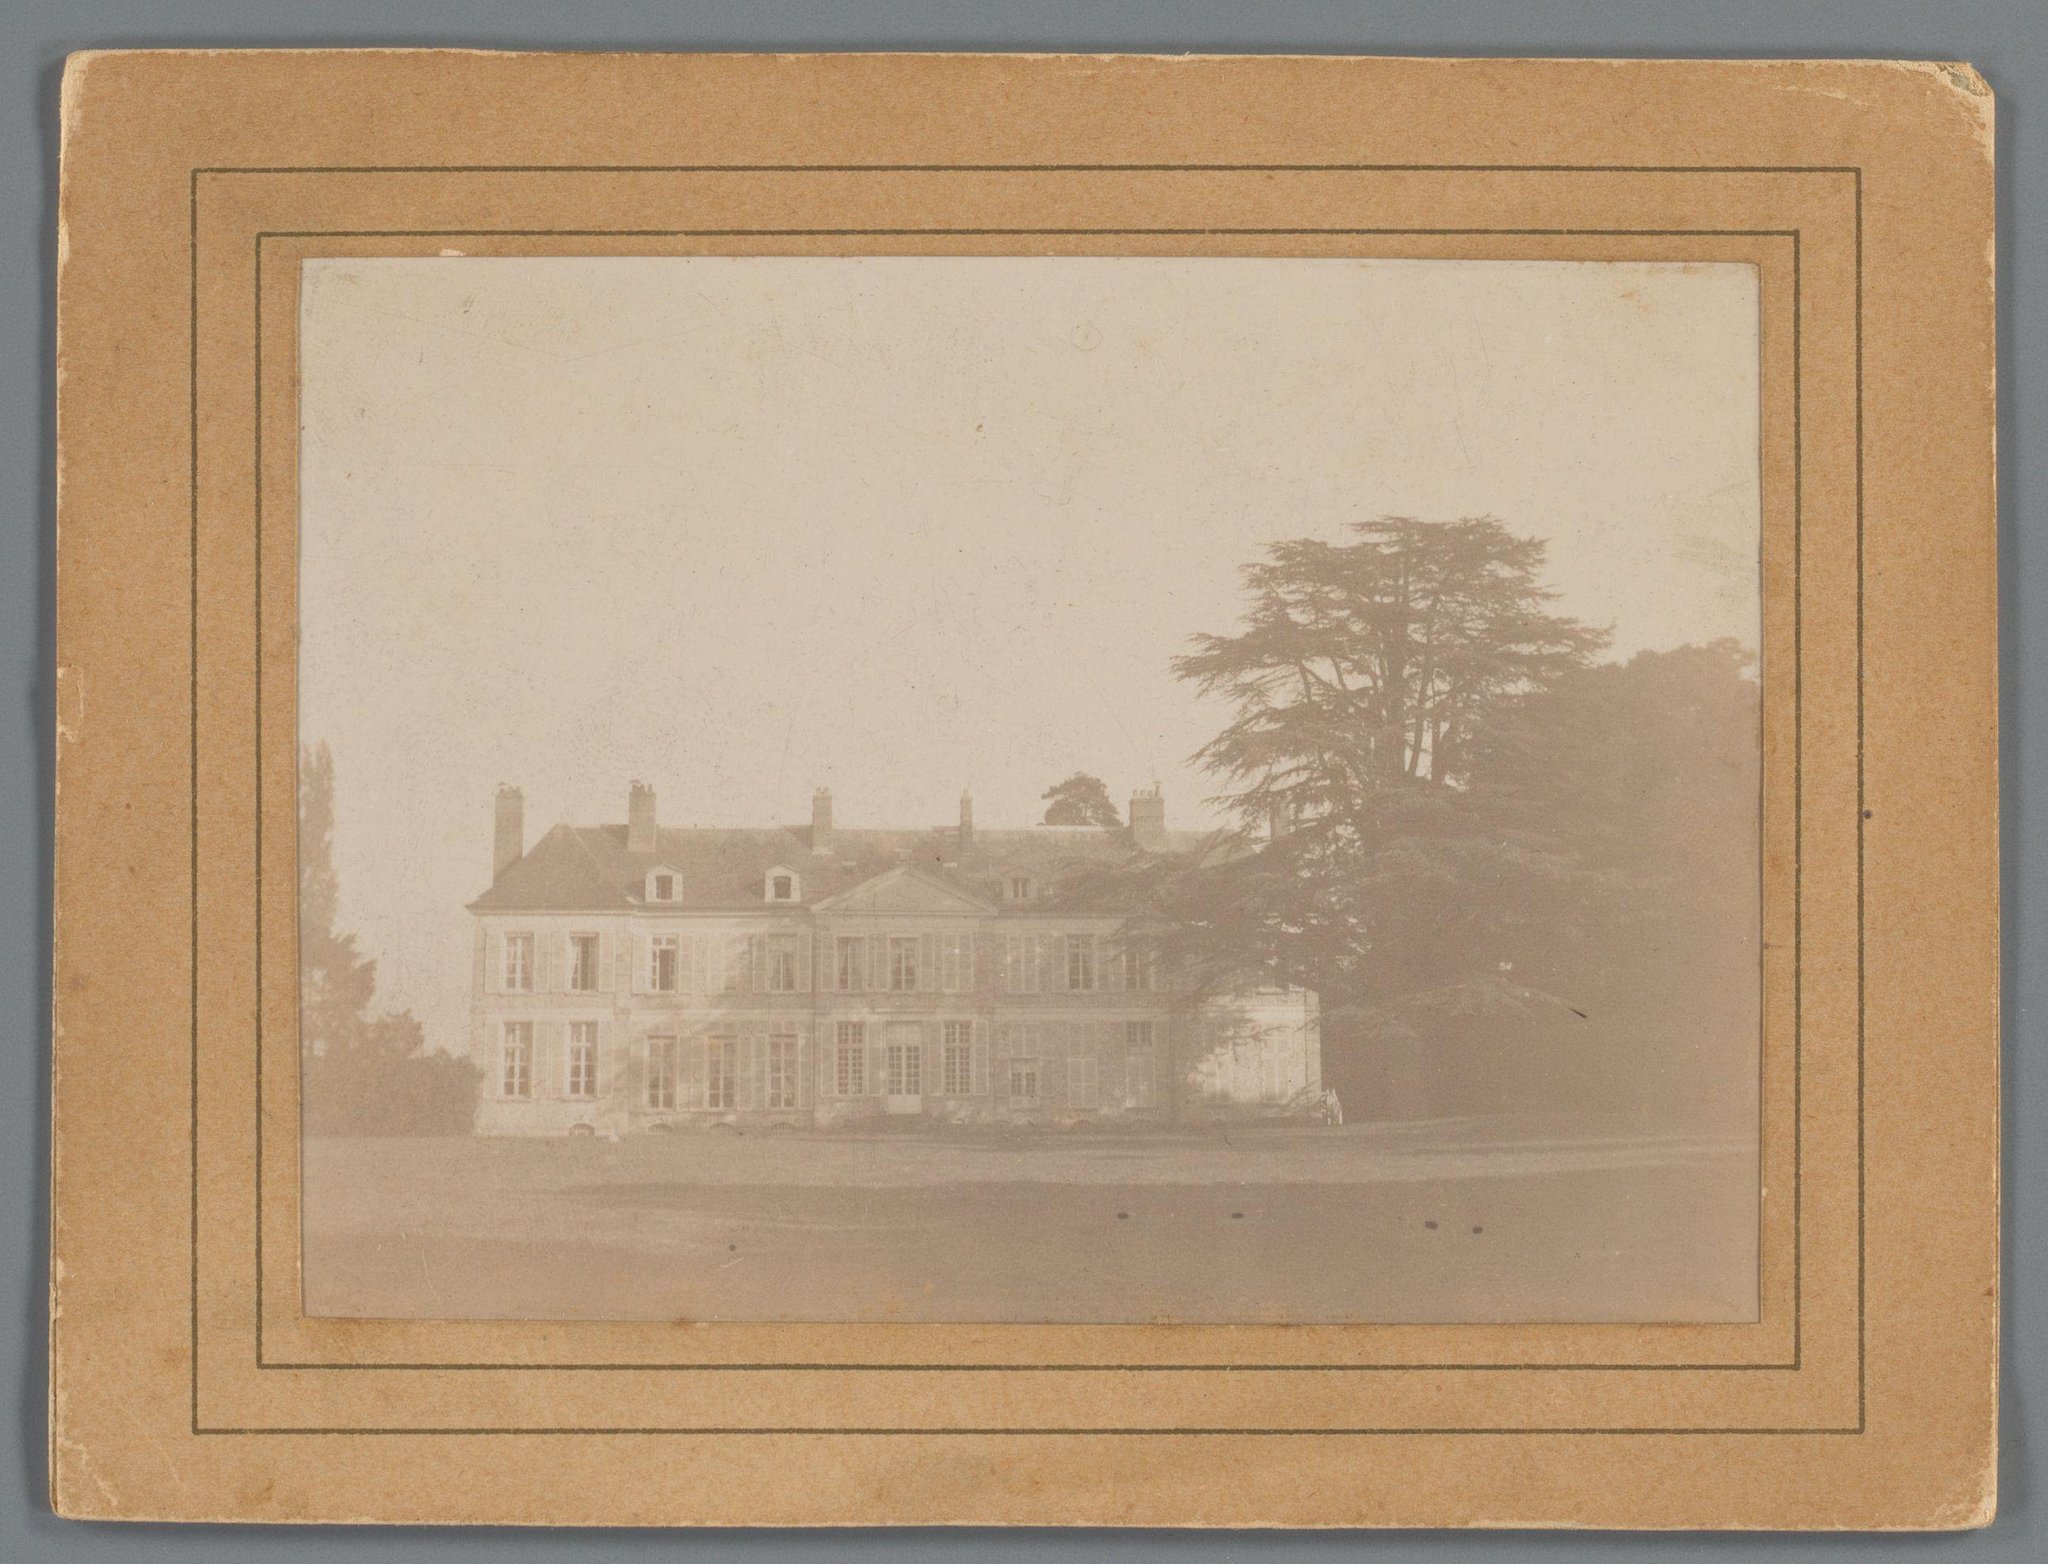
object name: photograph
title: Chateau de Coubertin, St Rémy les Chevreuse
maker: Anonymous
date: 1890-1930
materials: paper, cardboard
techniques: gelatin silver print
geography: saint-rémy-lès-chevreuse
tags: palace